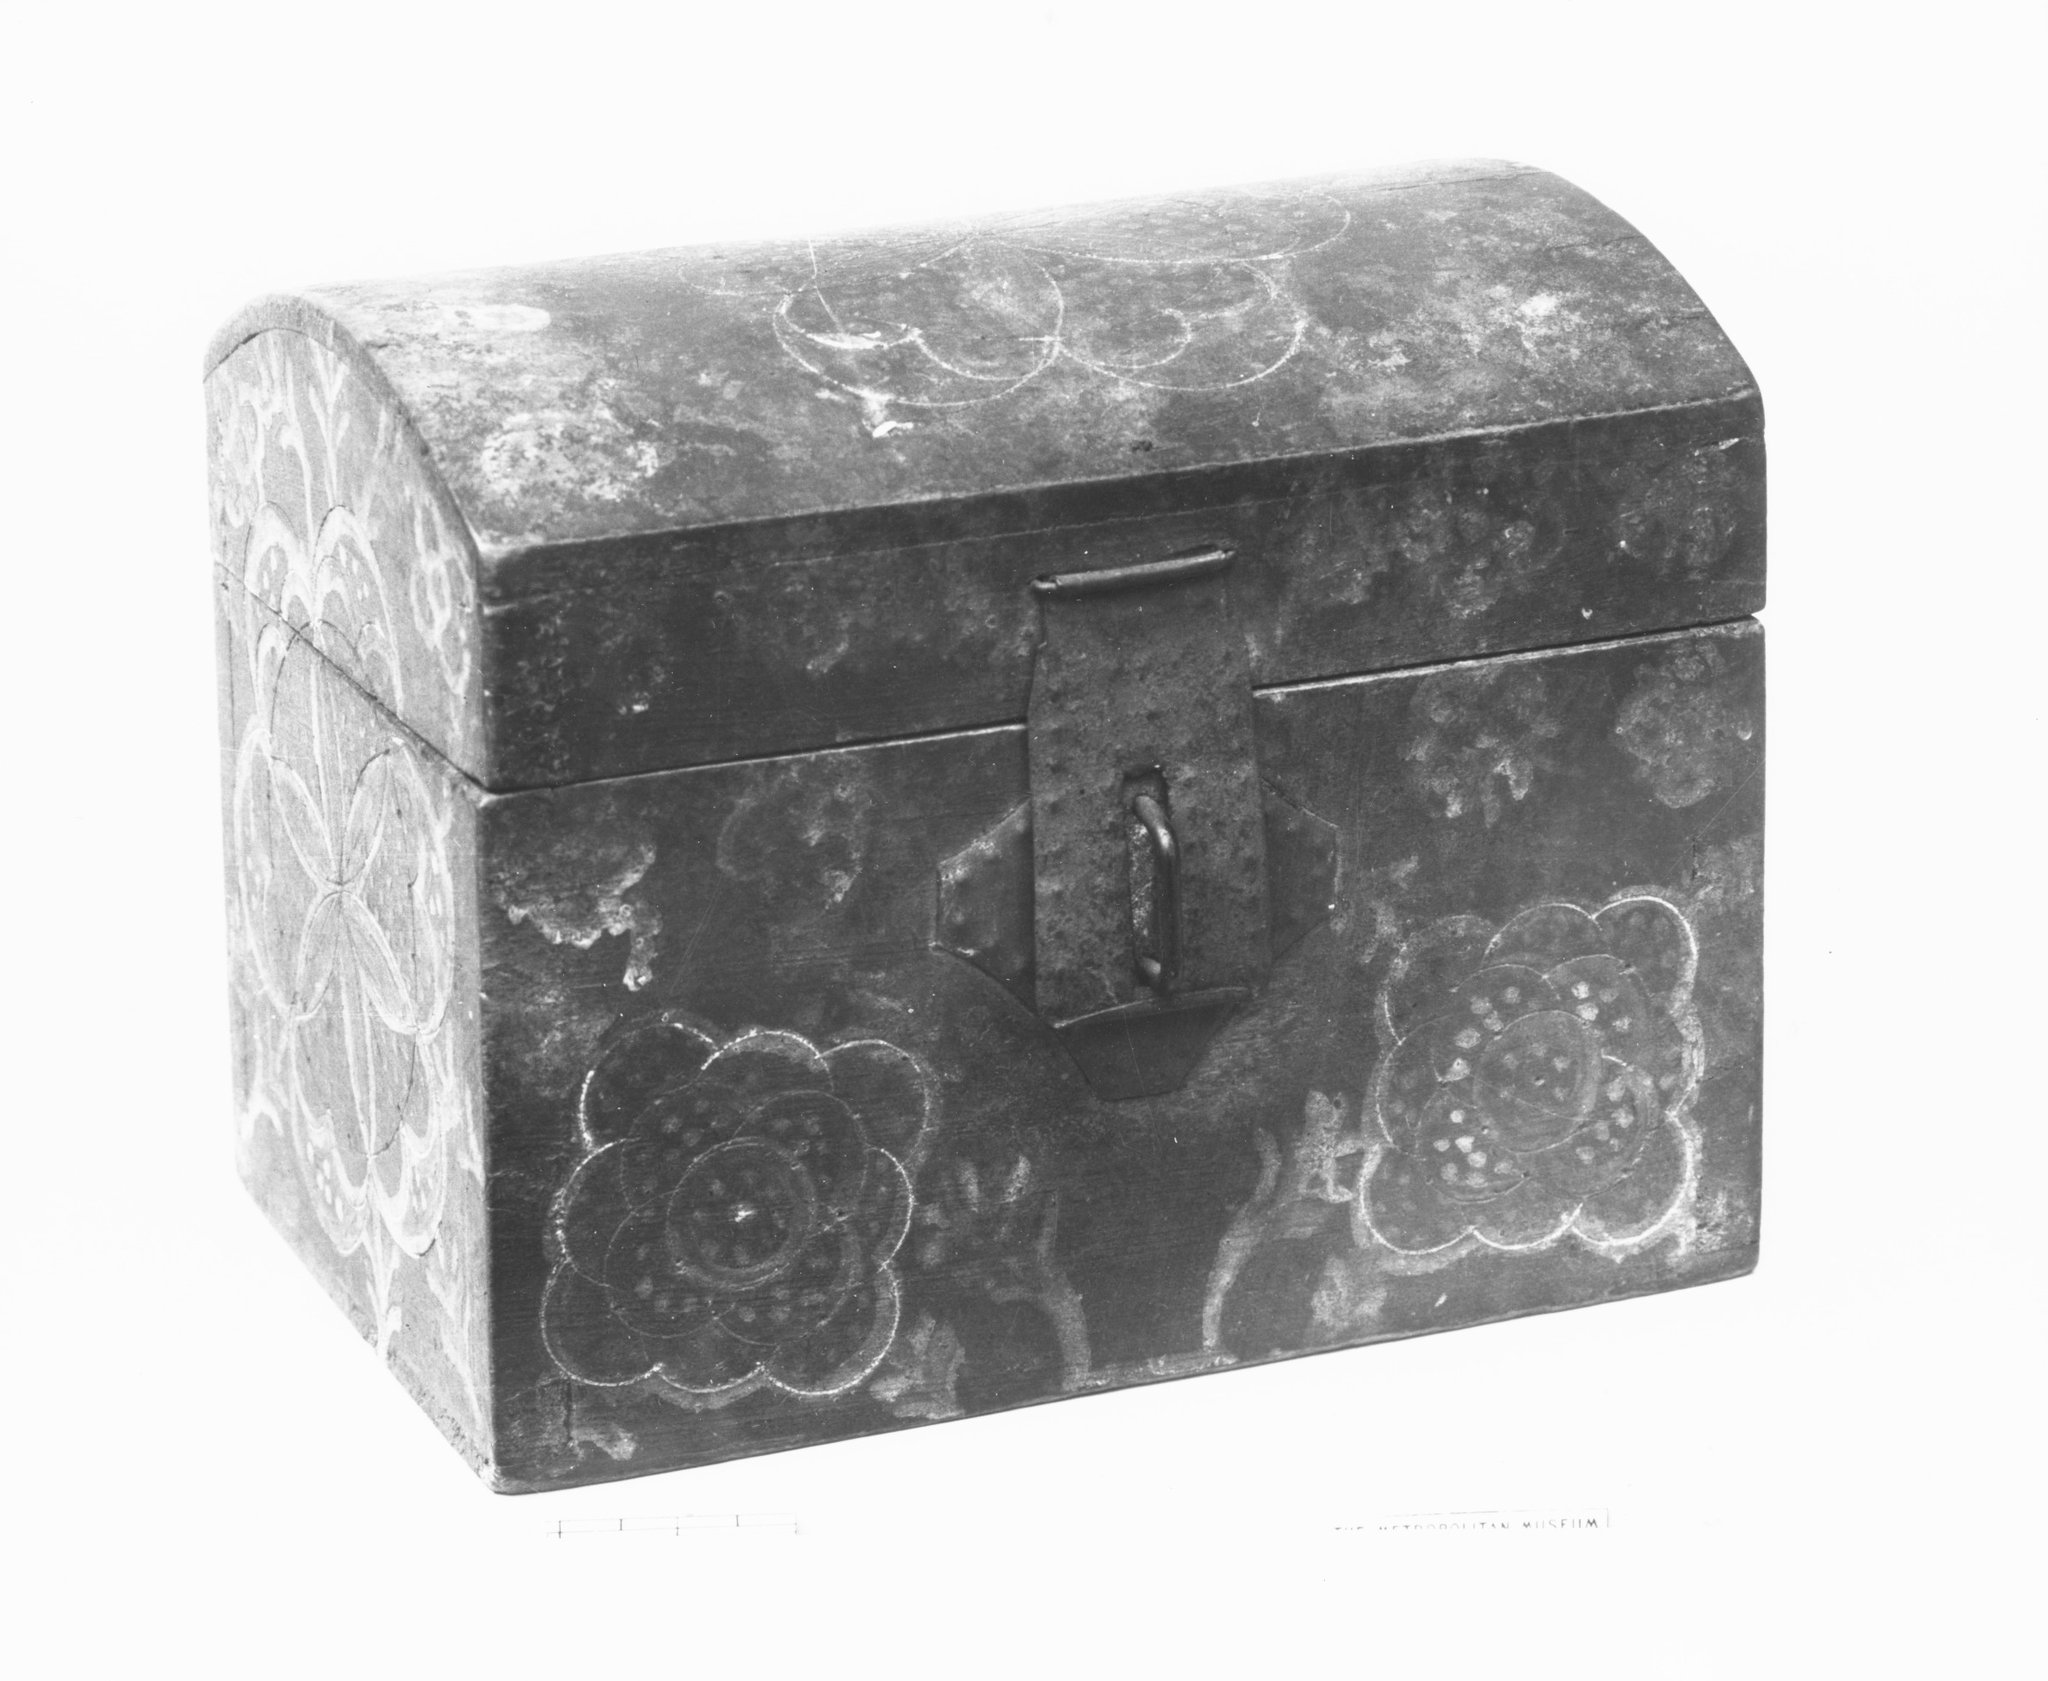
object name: trinket box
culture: american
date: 1800-1830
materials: wood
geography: united states